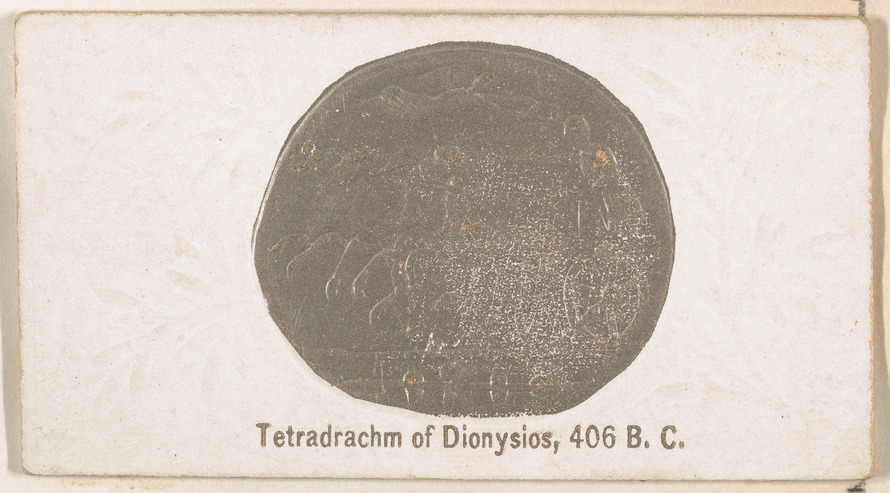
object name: print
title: Tetradrachm of Dionysios, 406 B.C., from the Ancient Coins series (N180) issued by Wm. S. Kimball & Co.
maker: william s. kimball & company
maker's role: publisher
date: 1888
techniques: color lithograph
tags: coins